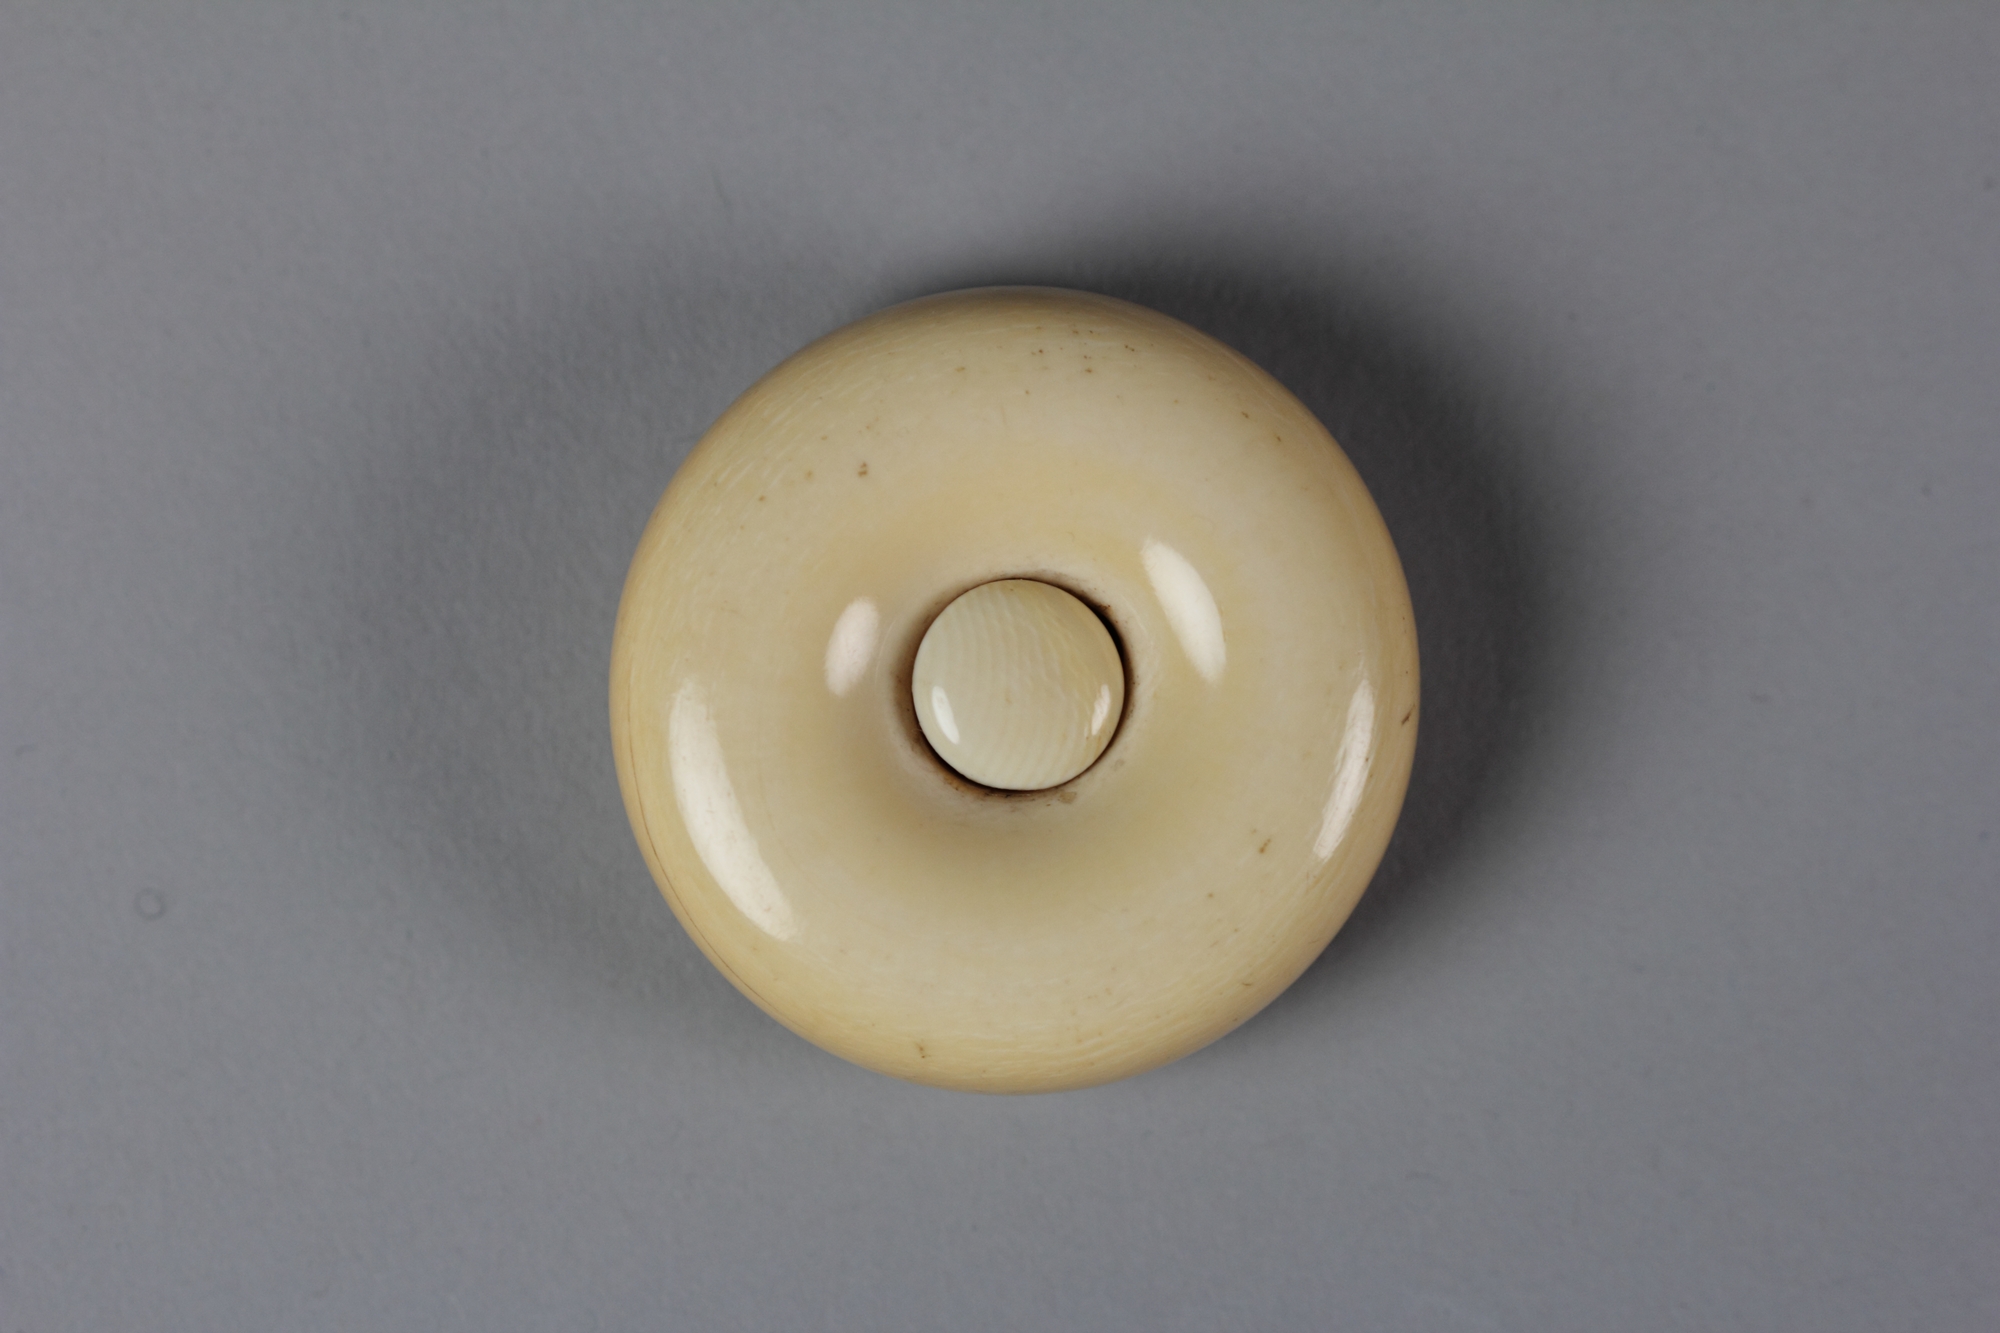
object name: netsuke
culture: japanese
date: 1701-1800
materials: ivory